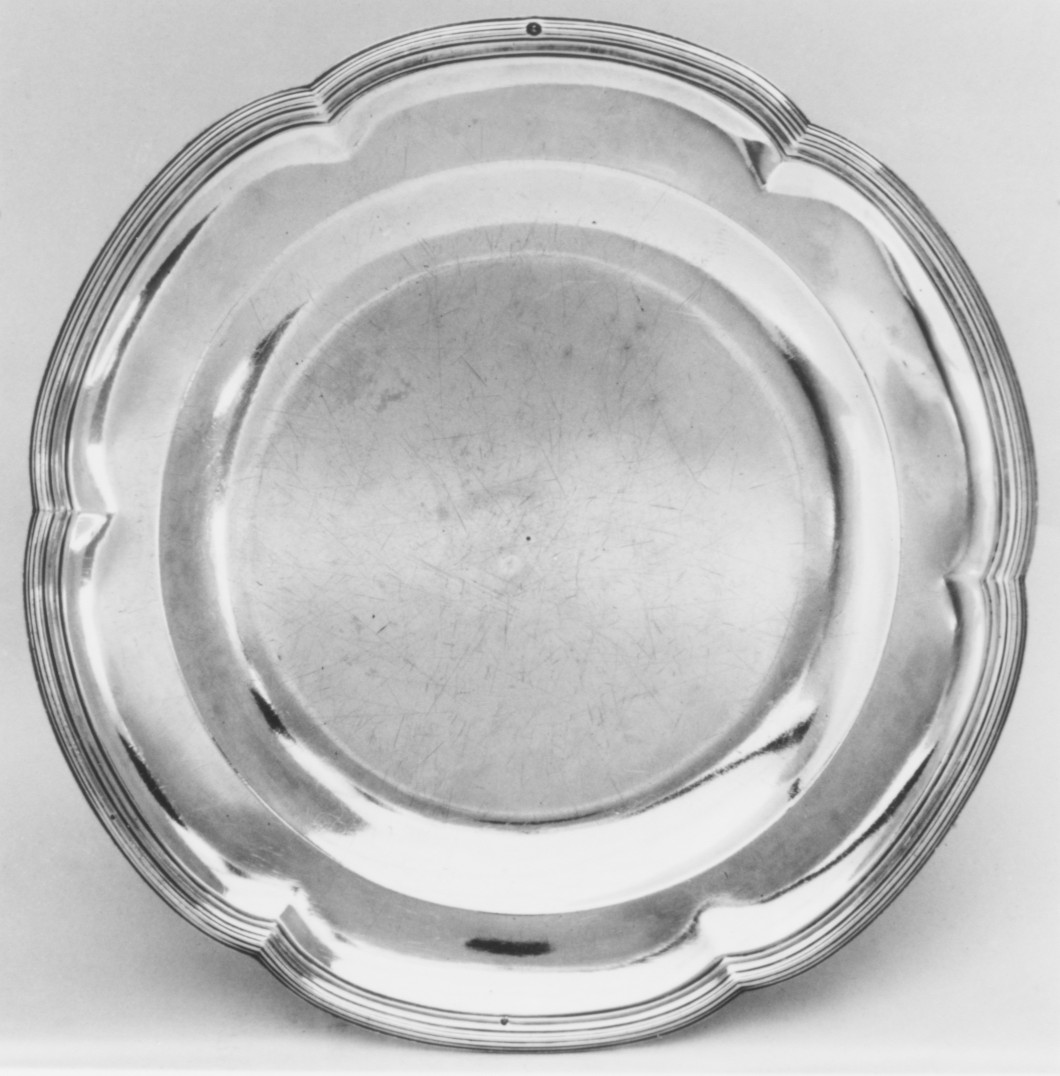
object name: plate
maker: robert joseph auguste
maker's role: maker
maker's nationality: french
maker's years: 1723-1805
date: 1781-1782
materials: silver